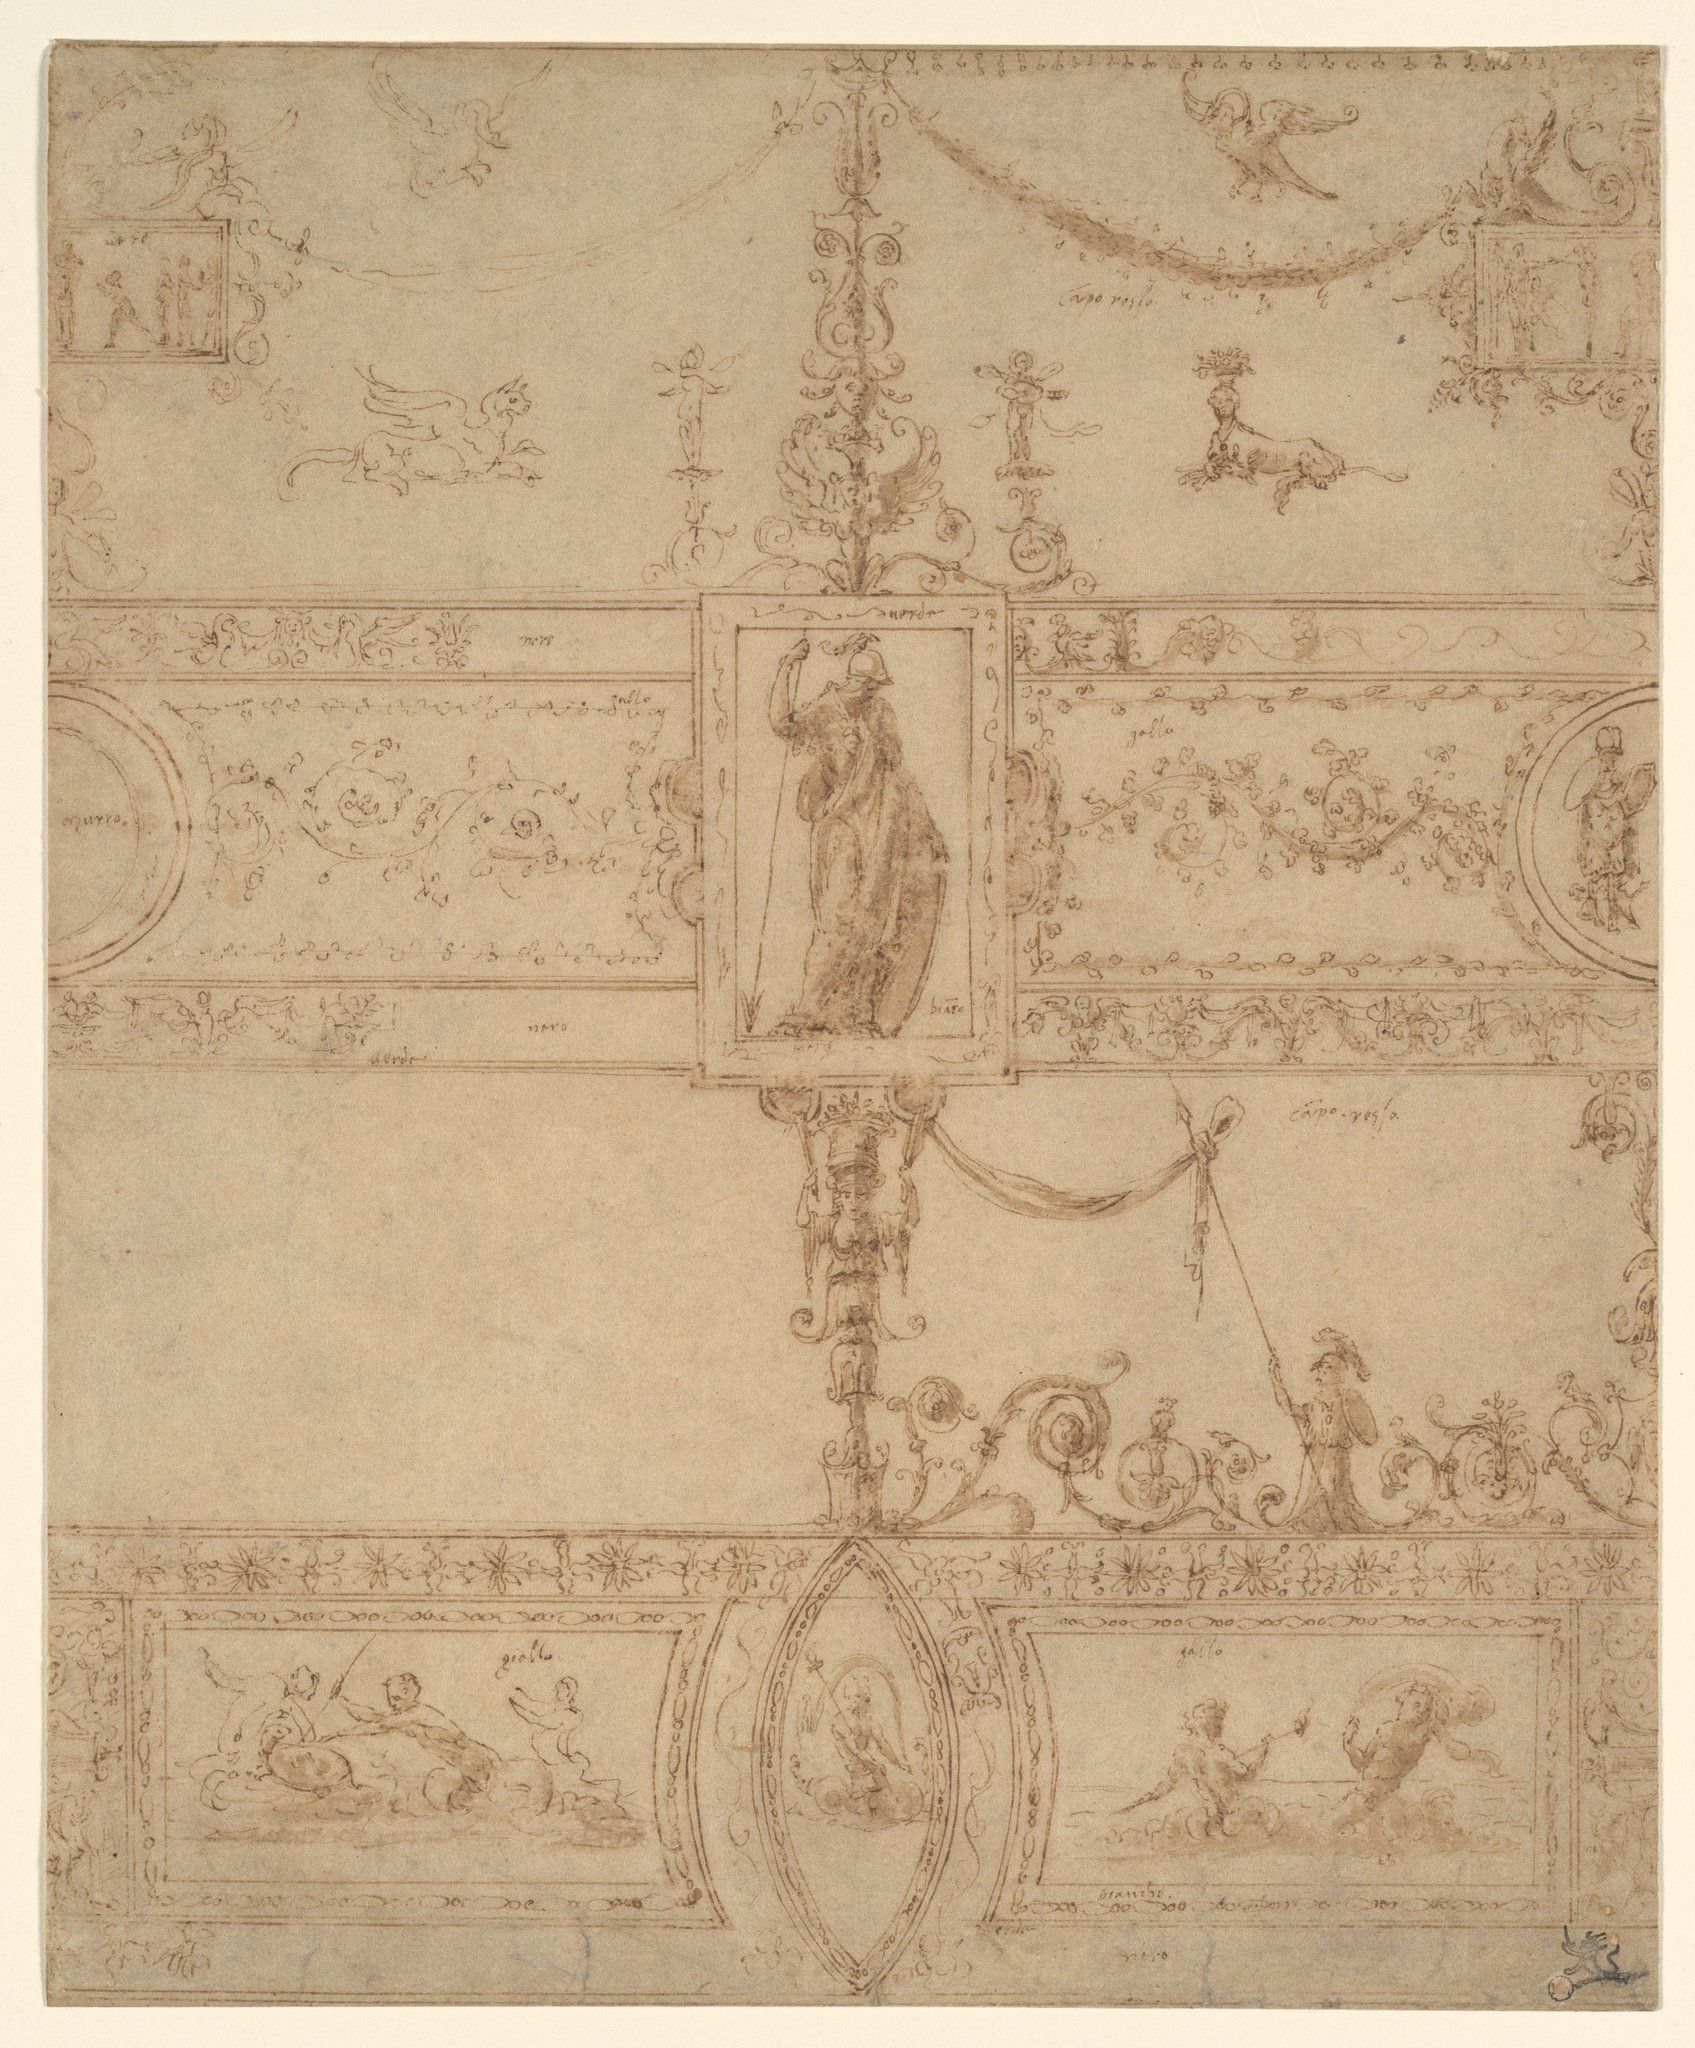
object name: drawing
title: Design for a Grotesque Decoration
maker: luzio luzzi (also known as luzio romano, luzio da todi)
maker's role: artist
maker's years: 1519-1582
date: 1543-1545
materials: ink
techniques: pen, wash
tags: ornament